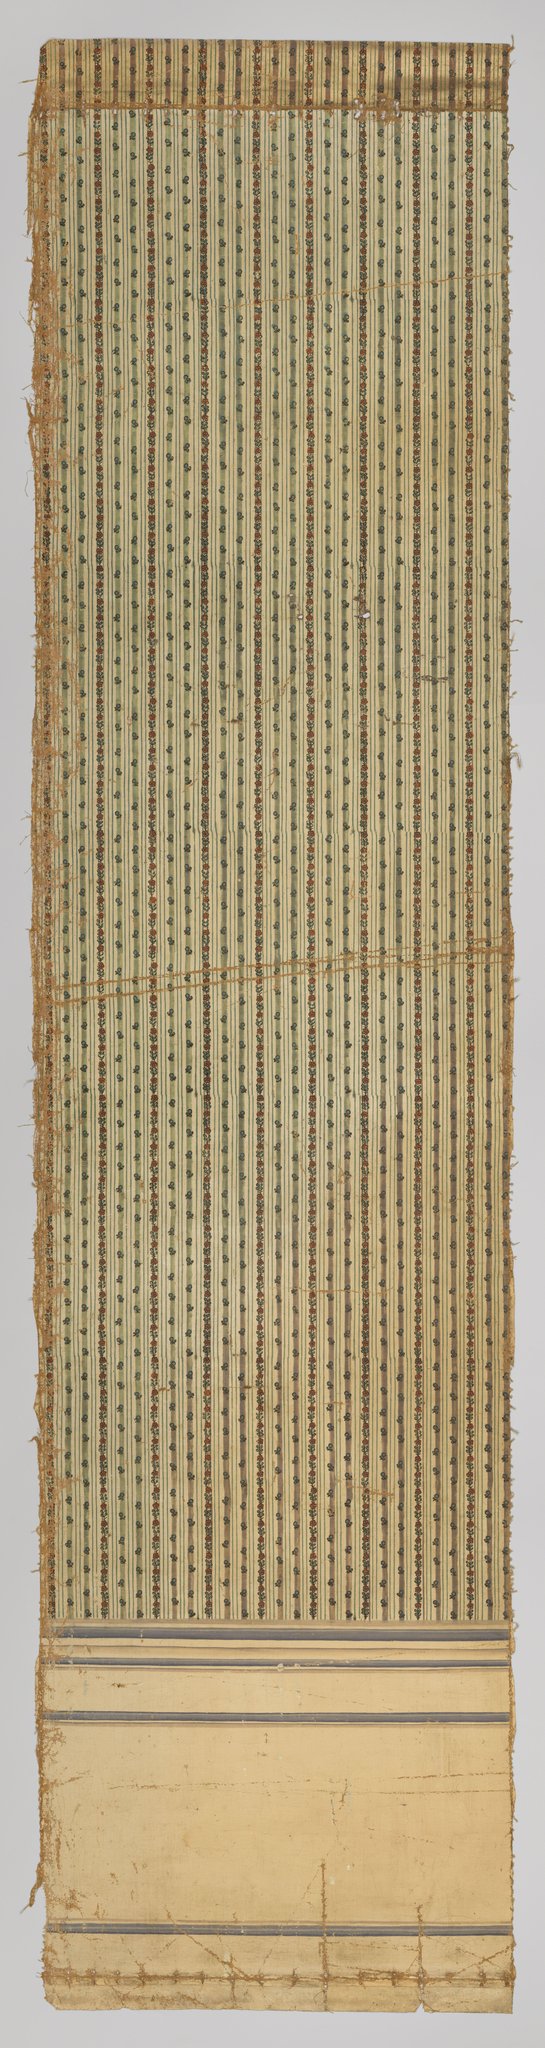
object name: interieuronderdeel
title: Twee banen van op linnen geschilderd behangsel met verticale strepen afwisselend versierd met takken met bessen en een bloemenrank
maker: Anonymous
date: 1785-1800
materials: linen, oil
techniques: painted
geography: netherlands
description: Twee banen in olieverf op linnen geschilderd behangsel. Boven een lambris van gebroken wit met blauwgrijze omlijstingen, zijn op een gebroken wit fond grijsblauwe verticale strepen aangebracht, afwisselend versierd met gestrooide takjes met bessen en een bloemenrank in rood en blauw.